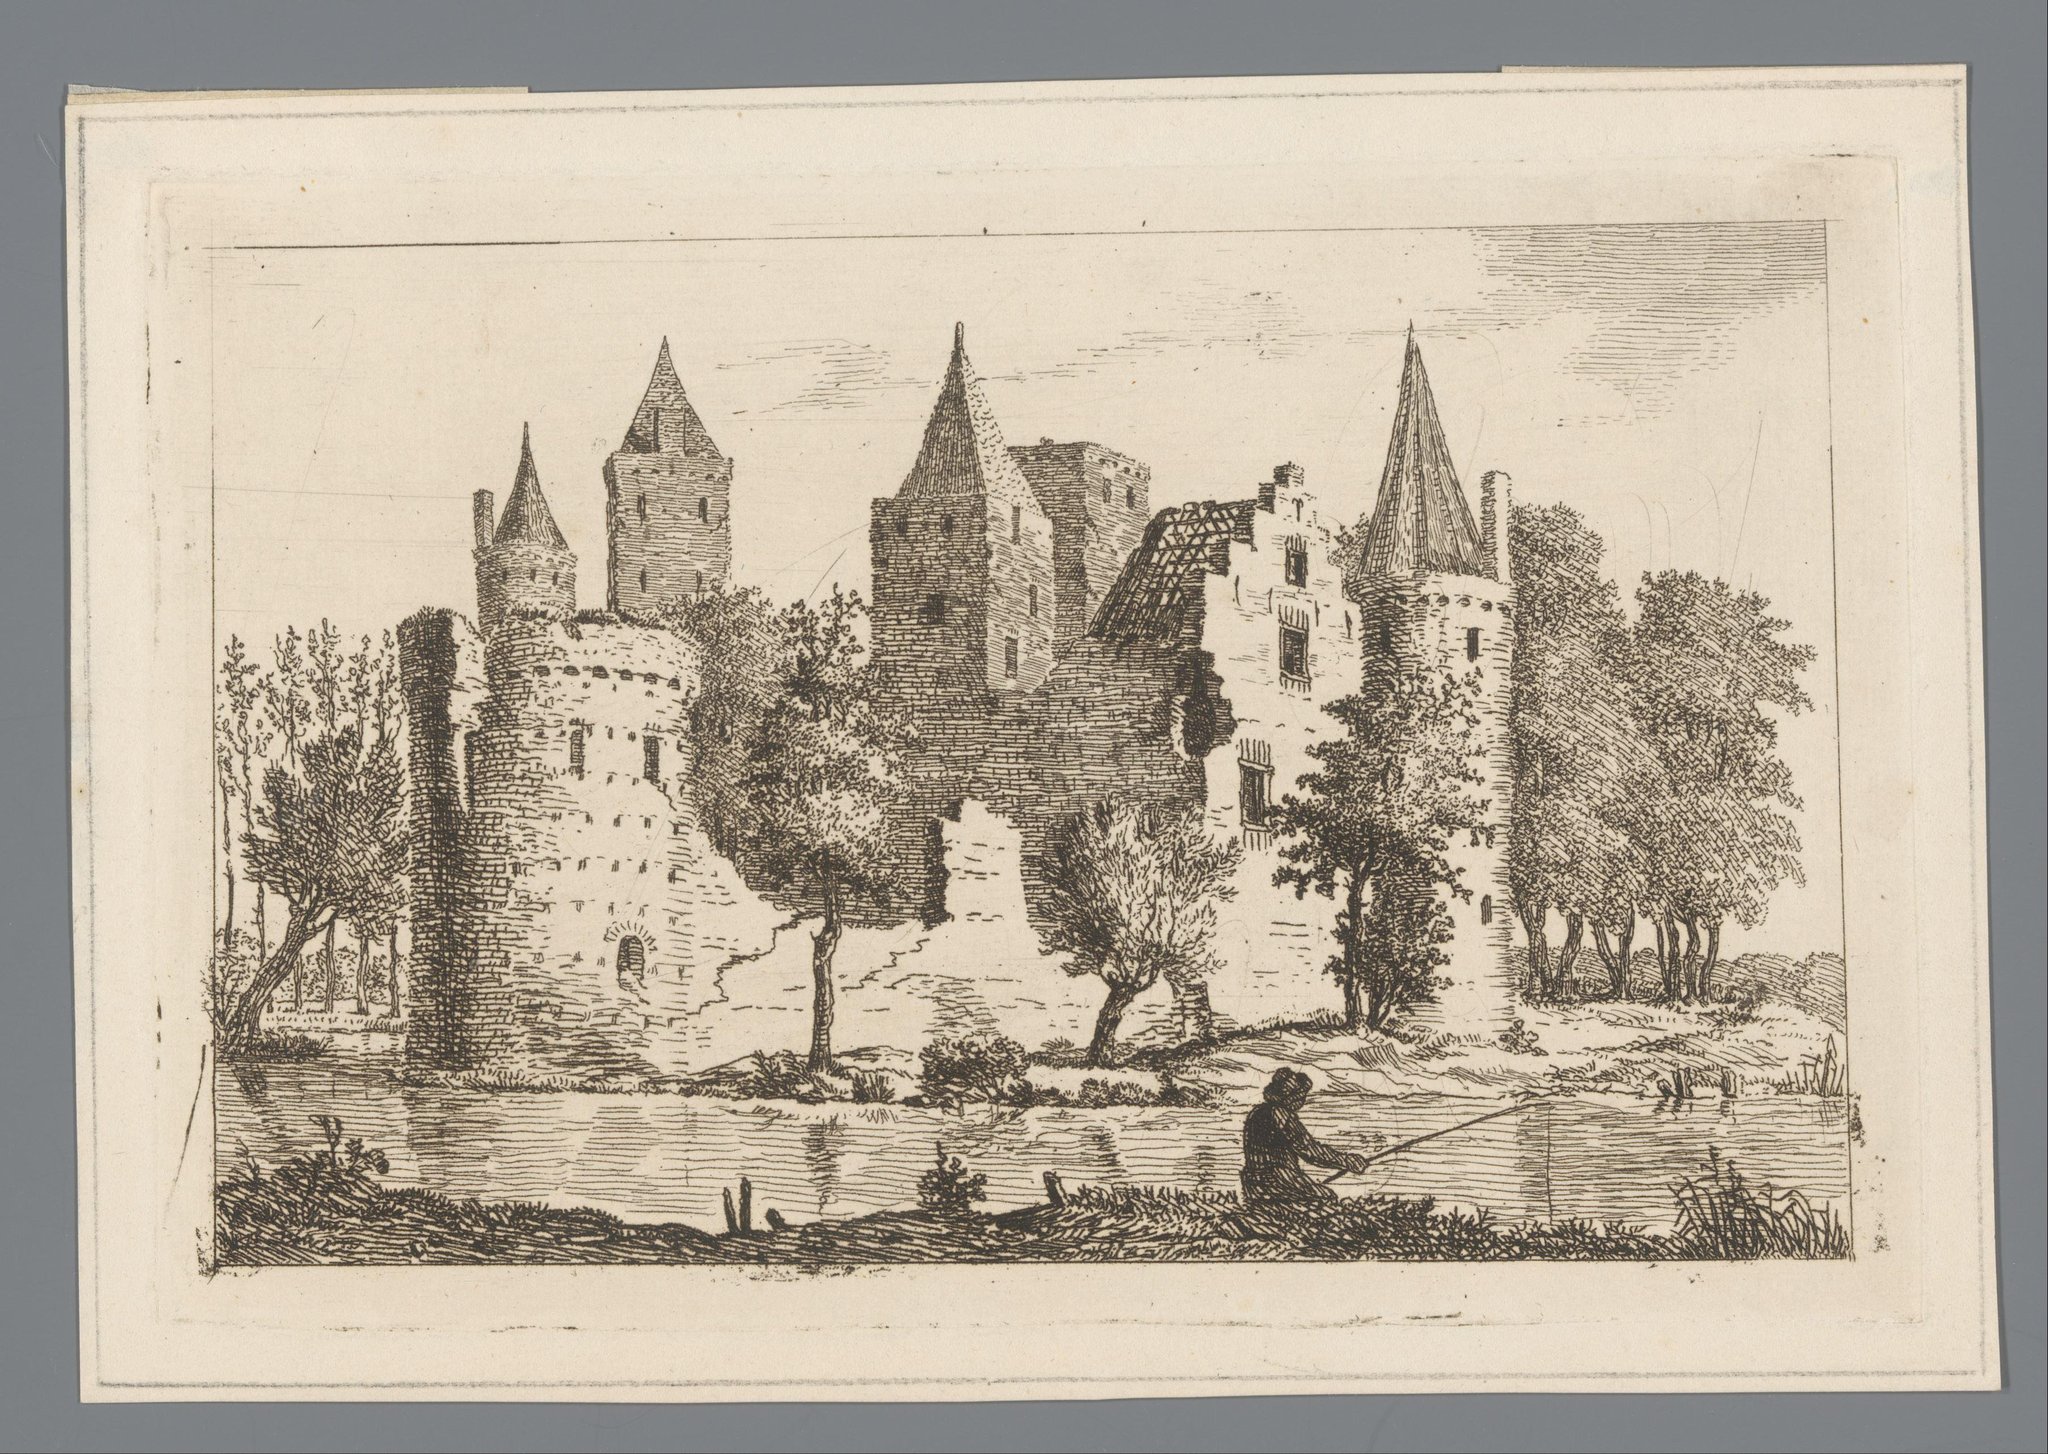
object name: print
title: Ruïne van kasteel De Haar in Haarzuilens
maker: anthonie van den bos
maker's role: draughtsman, print maker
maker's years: 1763-1838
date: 1790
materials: paper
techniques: etching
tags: castle, landscape with tower or castle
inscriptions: collector's mark: Lugt 2233